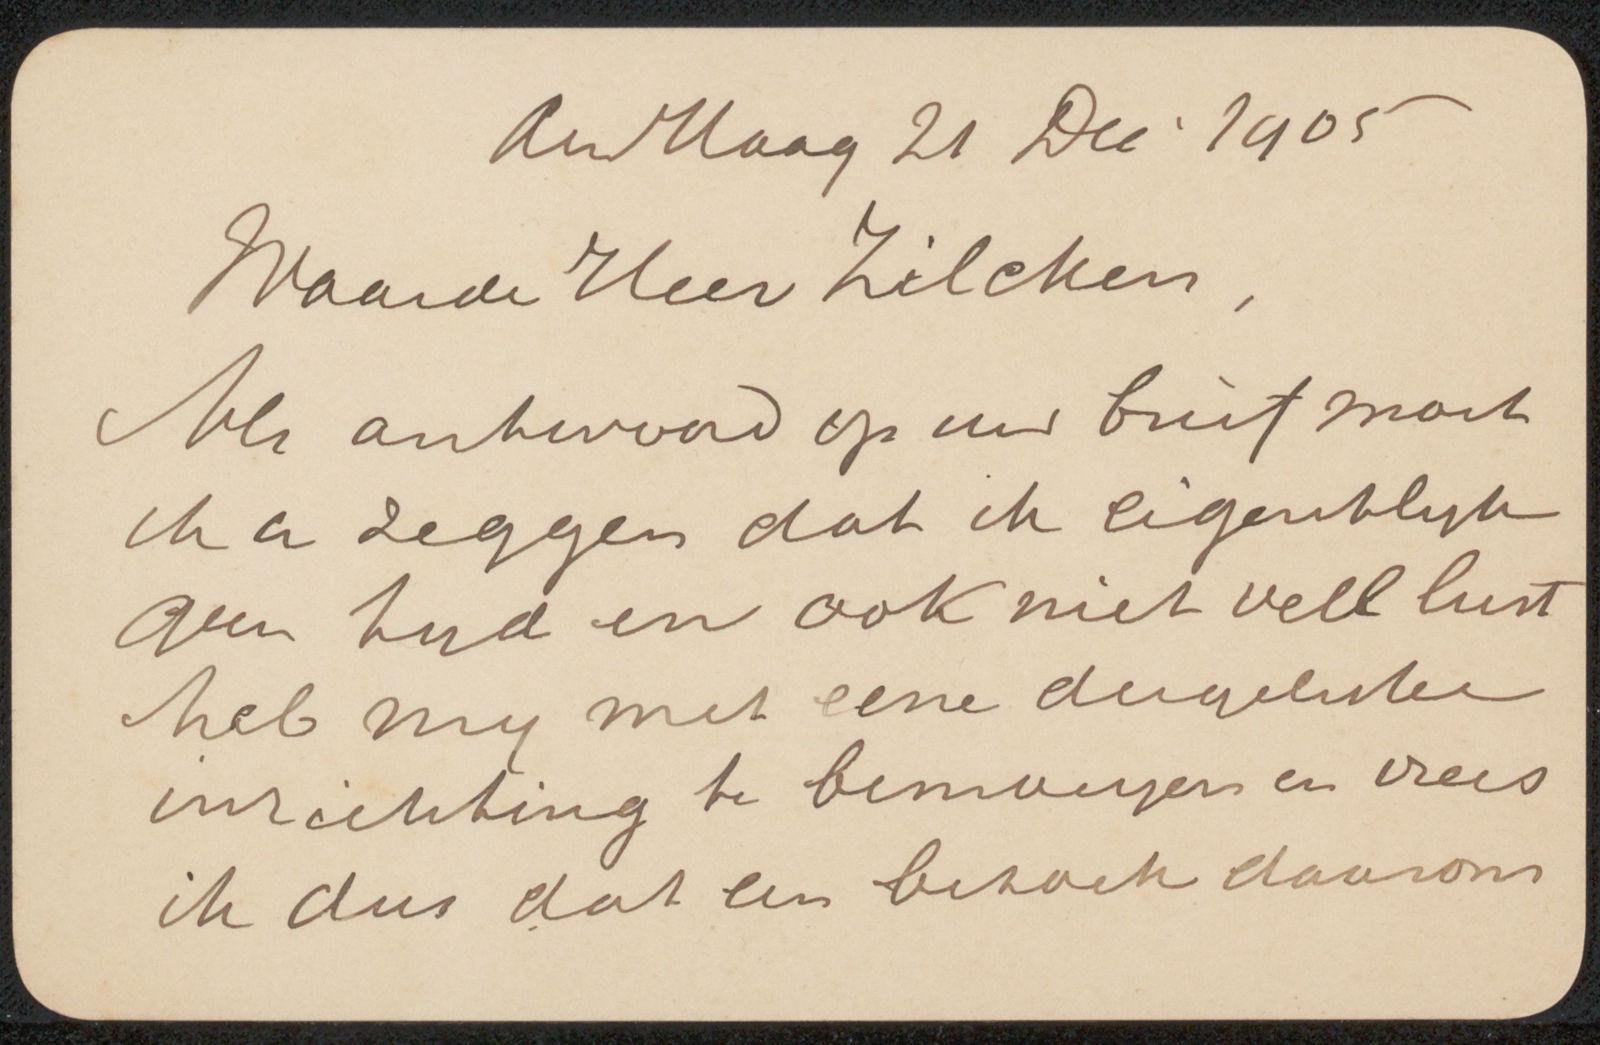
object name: letter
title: Brief aan Philip Zilcken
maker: sientje mesdag-van houten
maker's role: draughtsman, painter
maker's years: 1834-1909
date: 1905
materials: cardboard, ink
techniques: pen, writing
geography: the hague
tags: philip zilcken